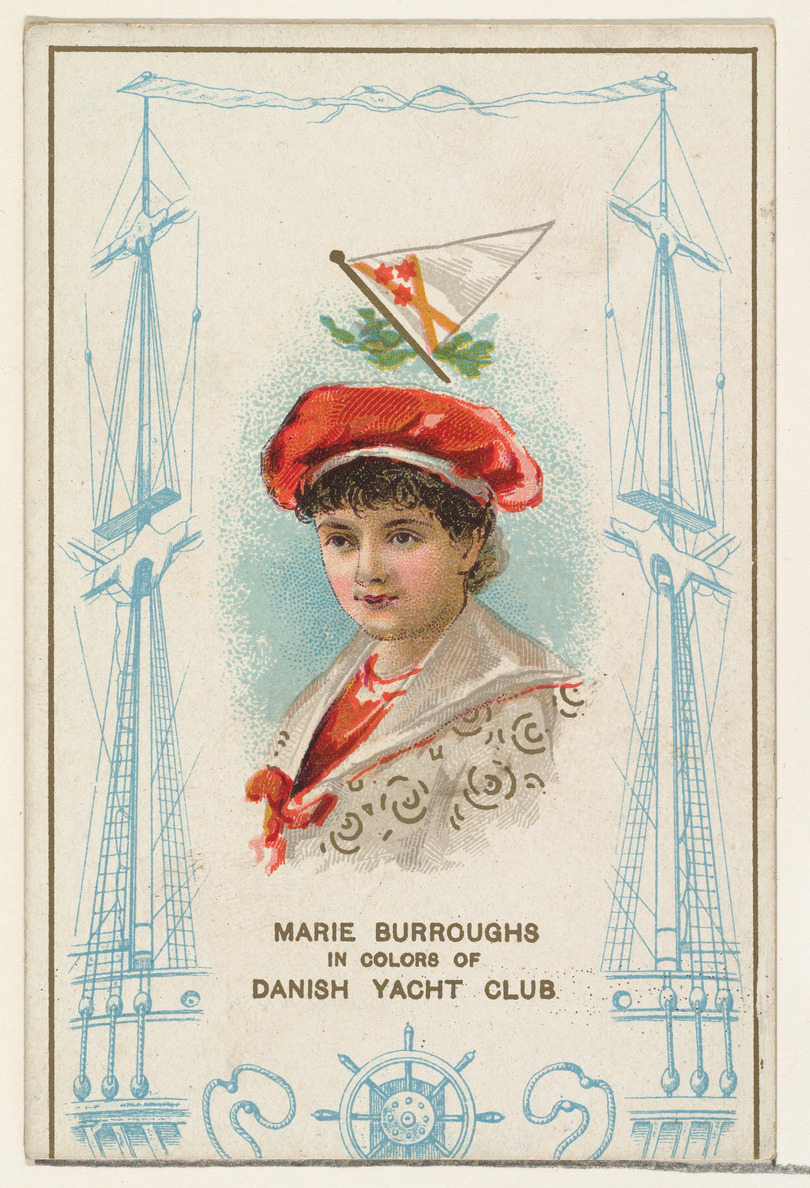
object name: print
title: Marie Burroughs in Colors of Danish Yacht Club, from the Yacht Colors of the World series (N140) issued by Duke Sons & Co. to promote Honest Long Cut Tobacco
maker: w. duke, sons & co.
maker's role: publisher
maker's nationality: american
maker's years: 1870-1920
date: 1890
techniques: color lithograph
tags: portraits,women,flags